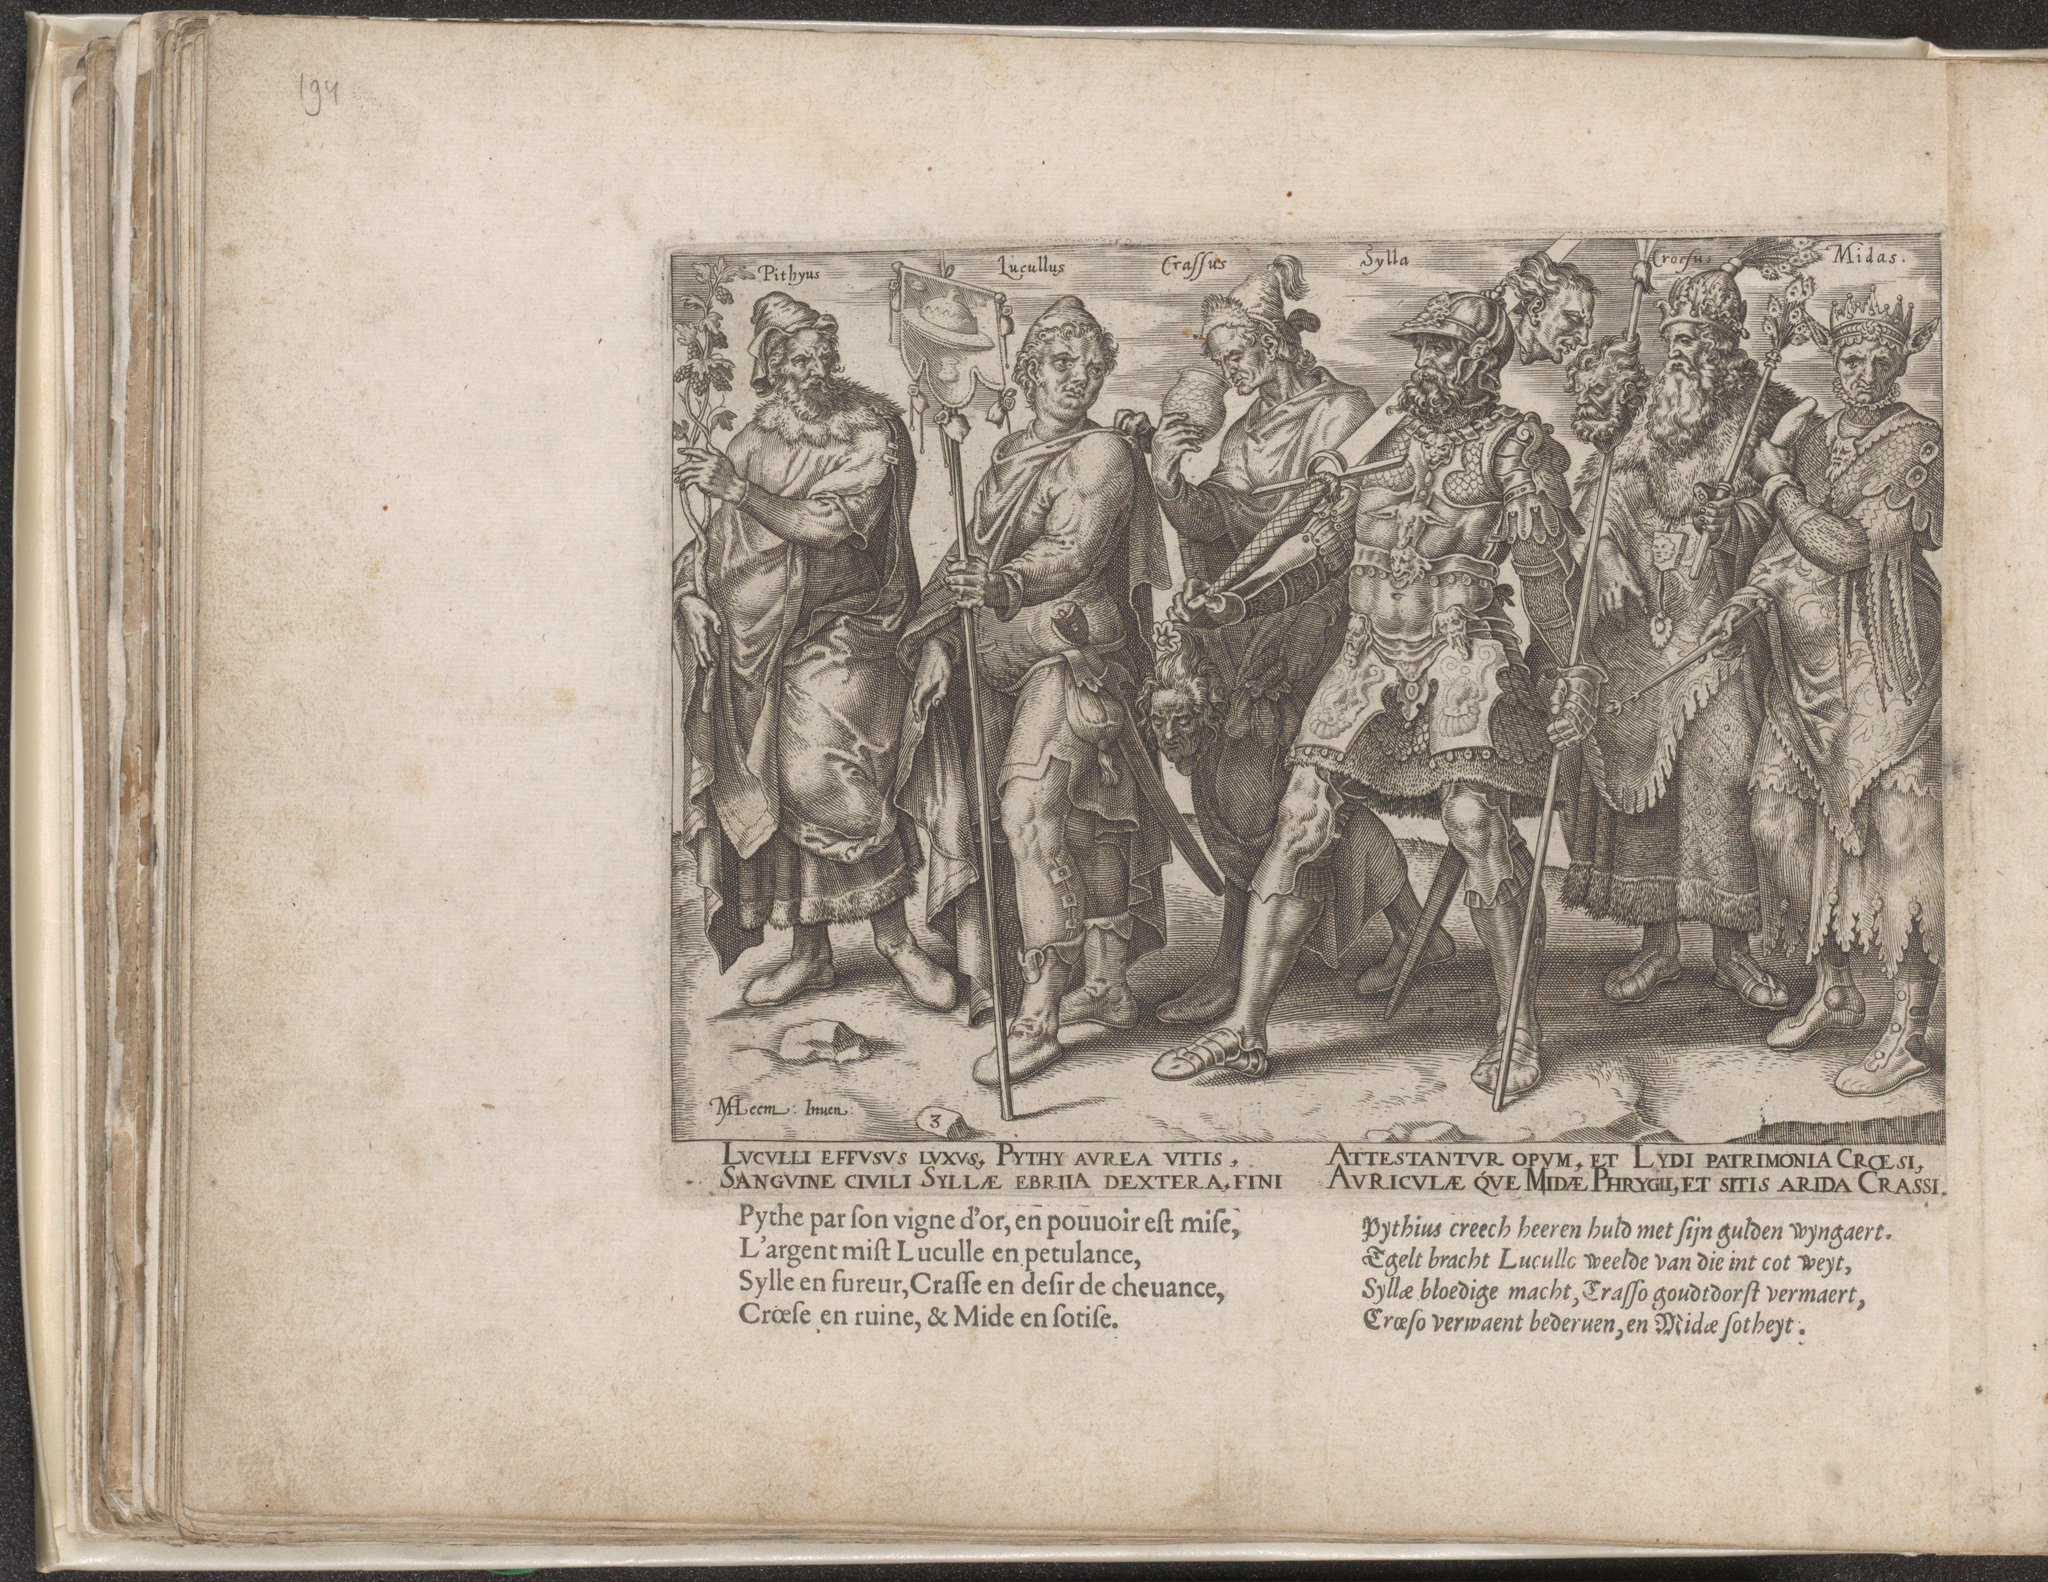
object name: print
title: Beroemde en beruchte rijkaards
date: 1563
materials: paper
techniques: engraving, letterpress printing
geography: haarlem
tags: contemplating one's own riches, (story of) m. licinius crassus, (story of) croesus king of lydia, (story of) midas, male persons from classical history (sulla), male persons from classical history (pythius), male persons from classical history (lucullus)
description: Een optocht van beroemde voorbeelden van rijkaards uit de Oudheid. Voorop in de stoet Pythius, met in zijn hand een van goud en edelstenen gemaakte wijnrank. Vervolgens Lucullus, de rijke Romeinse magistraat en veelvraat. Hij draagt een vaandel met een kippenpastei. Achter hem Crassus, die uit een beker drinkt. Dit is een allusie op zijn dorst naar geld en zijn dood (gestikt in gesmolten goud). Na Crassus komen de dictator Sulla met een zwaard en een lans, Croesus als rijkgeklede koning en Midas met Midasoren onder zijn kroon. Onder de voorstelling een vers in het Latijn en een Frans en Nederlands onderschrift in boekdruk. Deze prent maakt deel uit van een album.